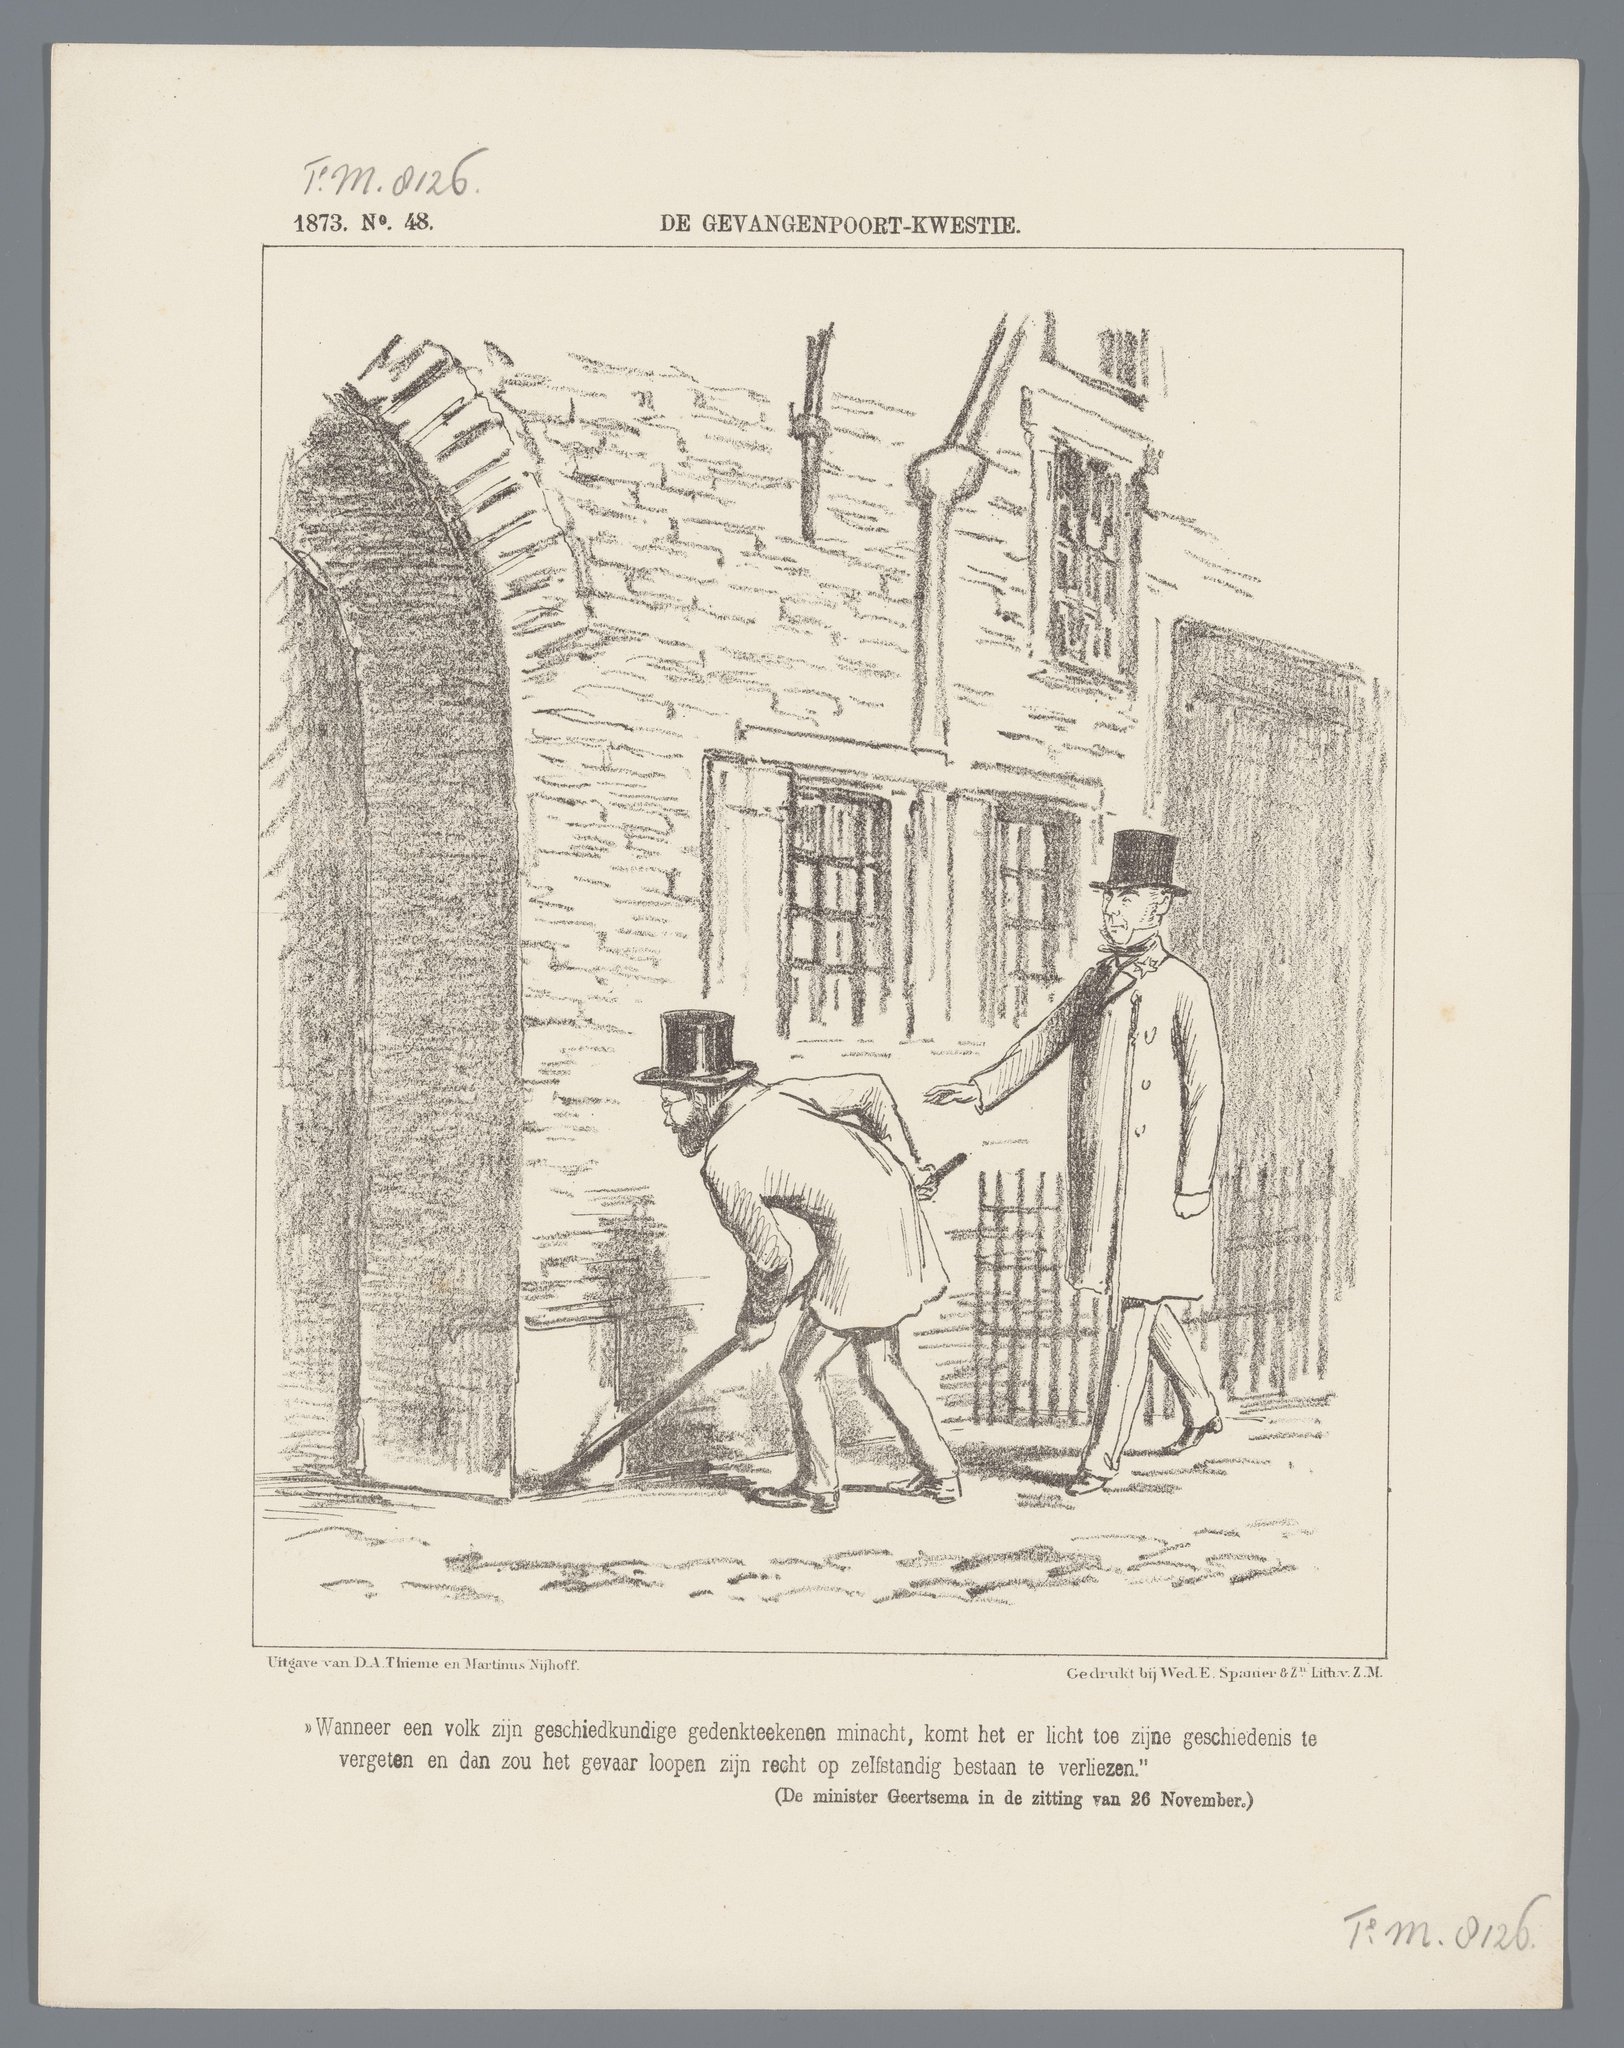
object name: print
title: De Gevangenpoort-kwestie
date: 1873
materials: paper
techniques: lithograph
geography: the hague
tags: tweede kamerlid, daniël van eck, gevangenpoort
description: Spotprent op het voorstel van kamerlid Mr. Daniël van Eck om het onderhoud van de Gevangenpoort van de begroting te schrappen. Plaat verschenen bij het weekblad De Nederlandsche Spectator, nr. 48, 1873.